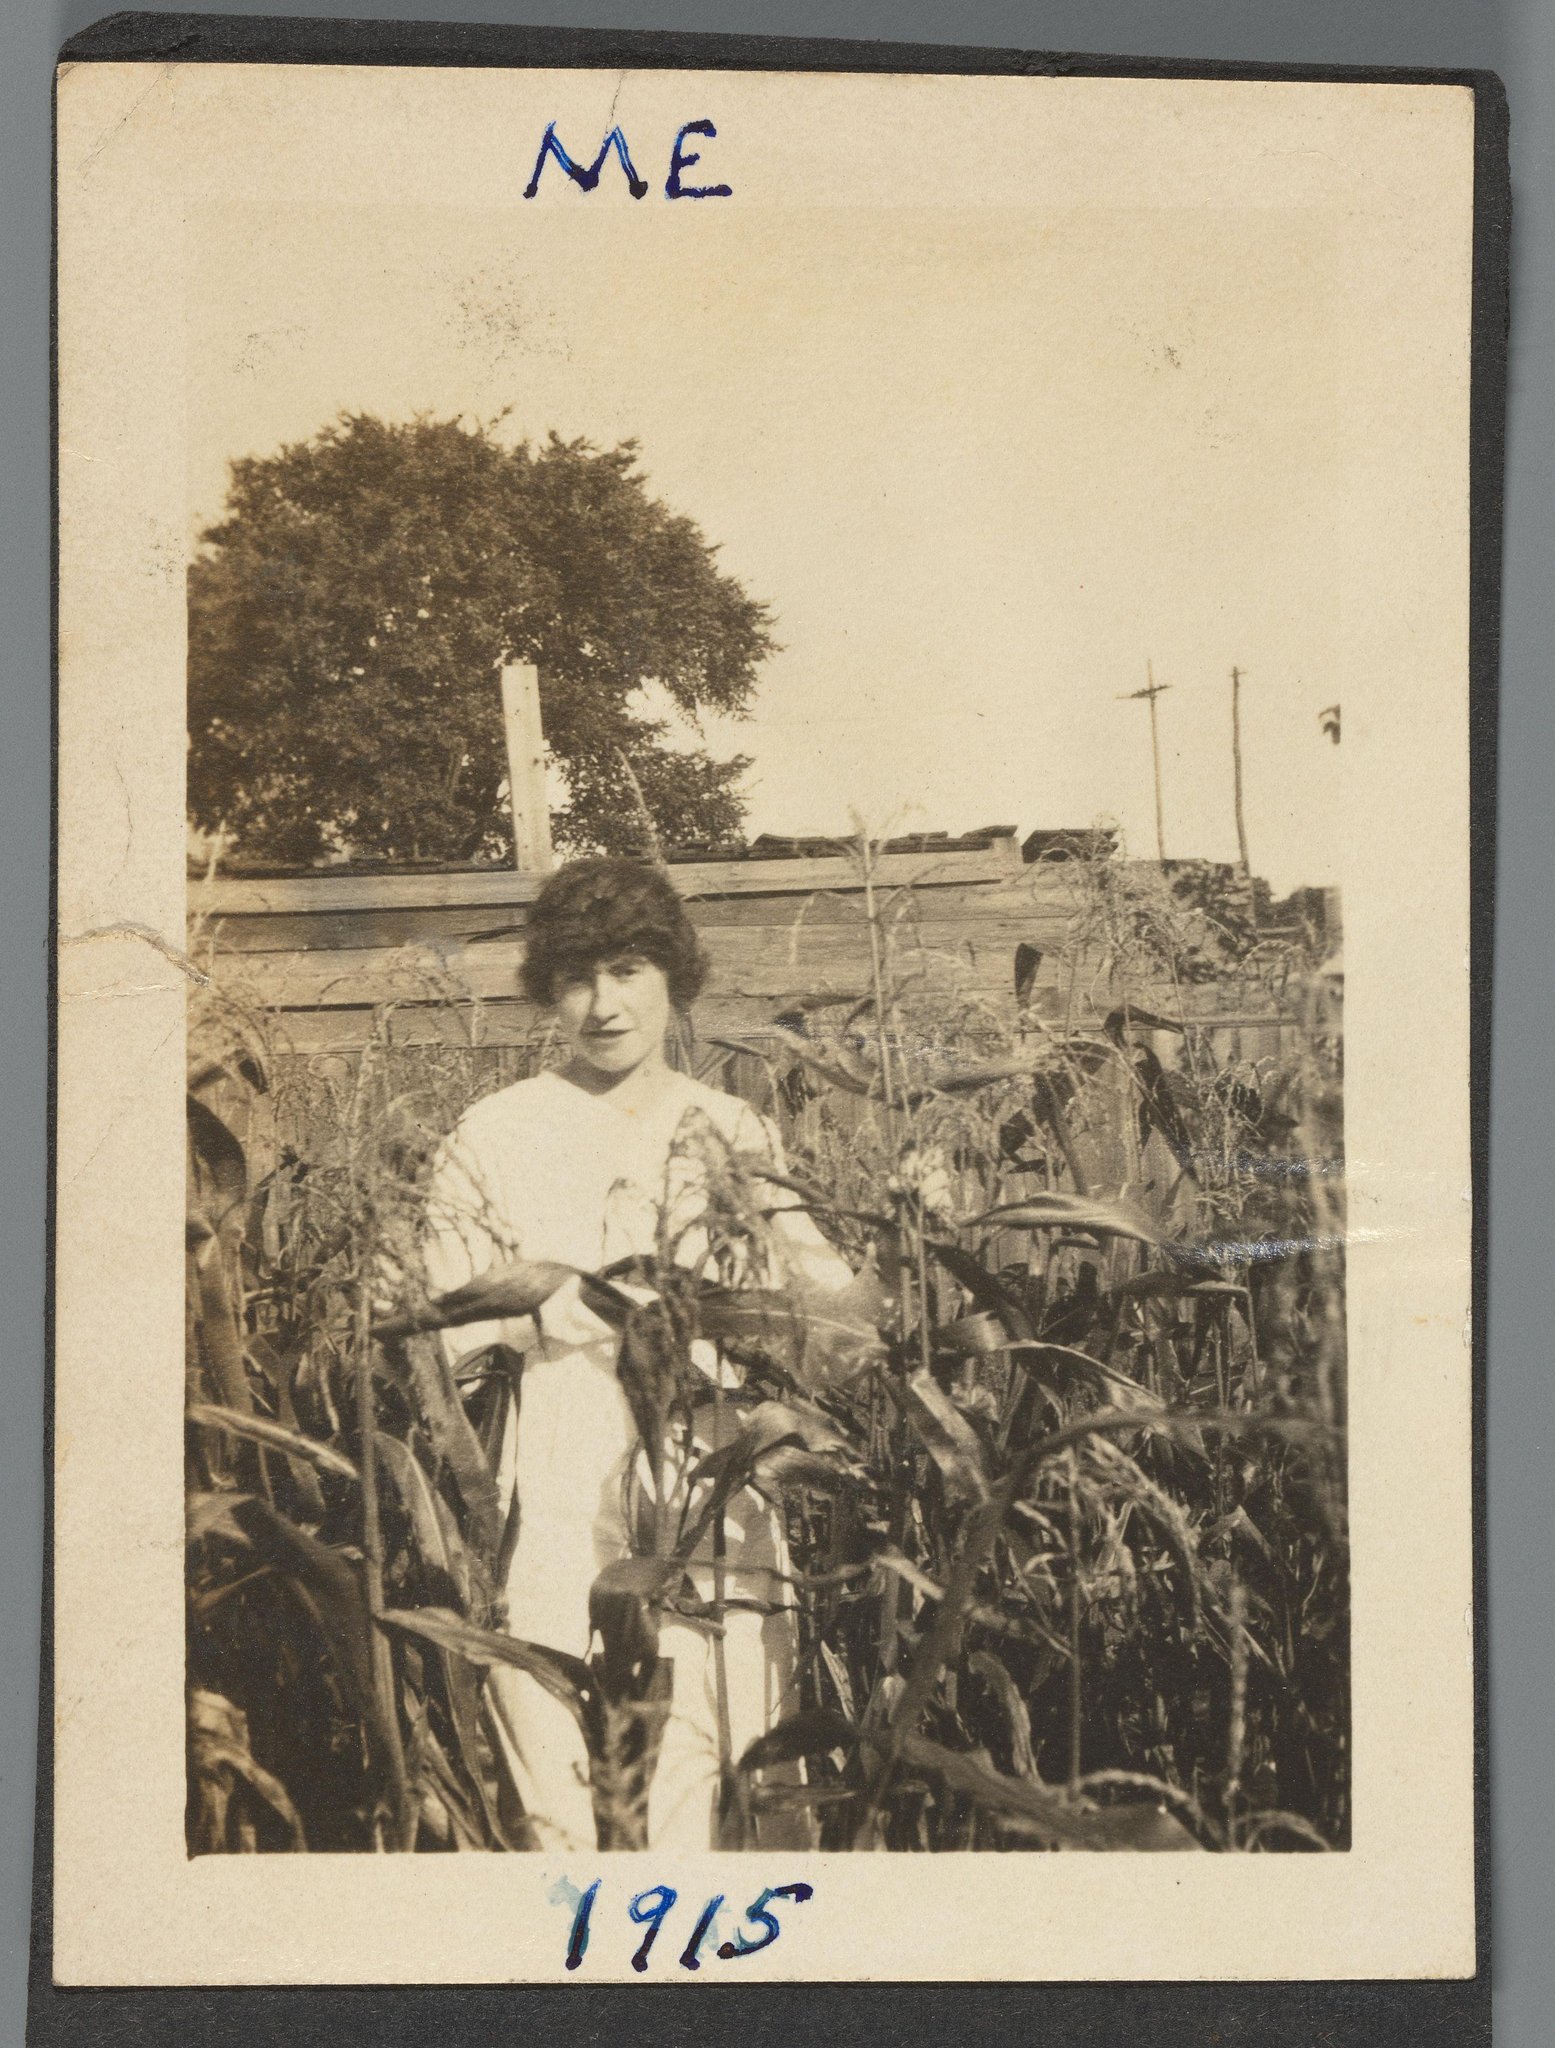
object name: photograph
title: Portret van jonge vrouw tussen het mais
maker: Anonymous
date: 1915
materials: paper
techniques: gelatin silver print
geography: united states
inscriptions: date: ‘1915’, stamp, inscription: ‘Me’